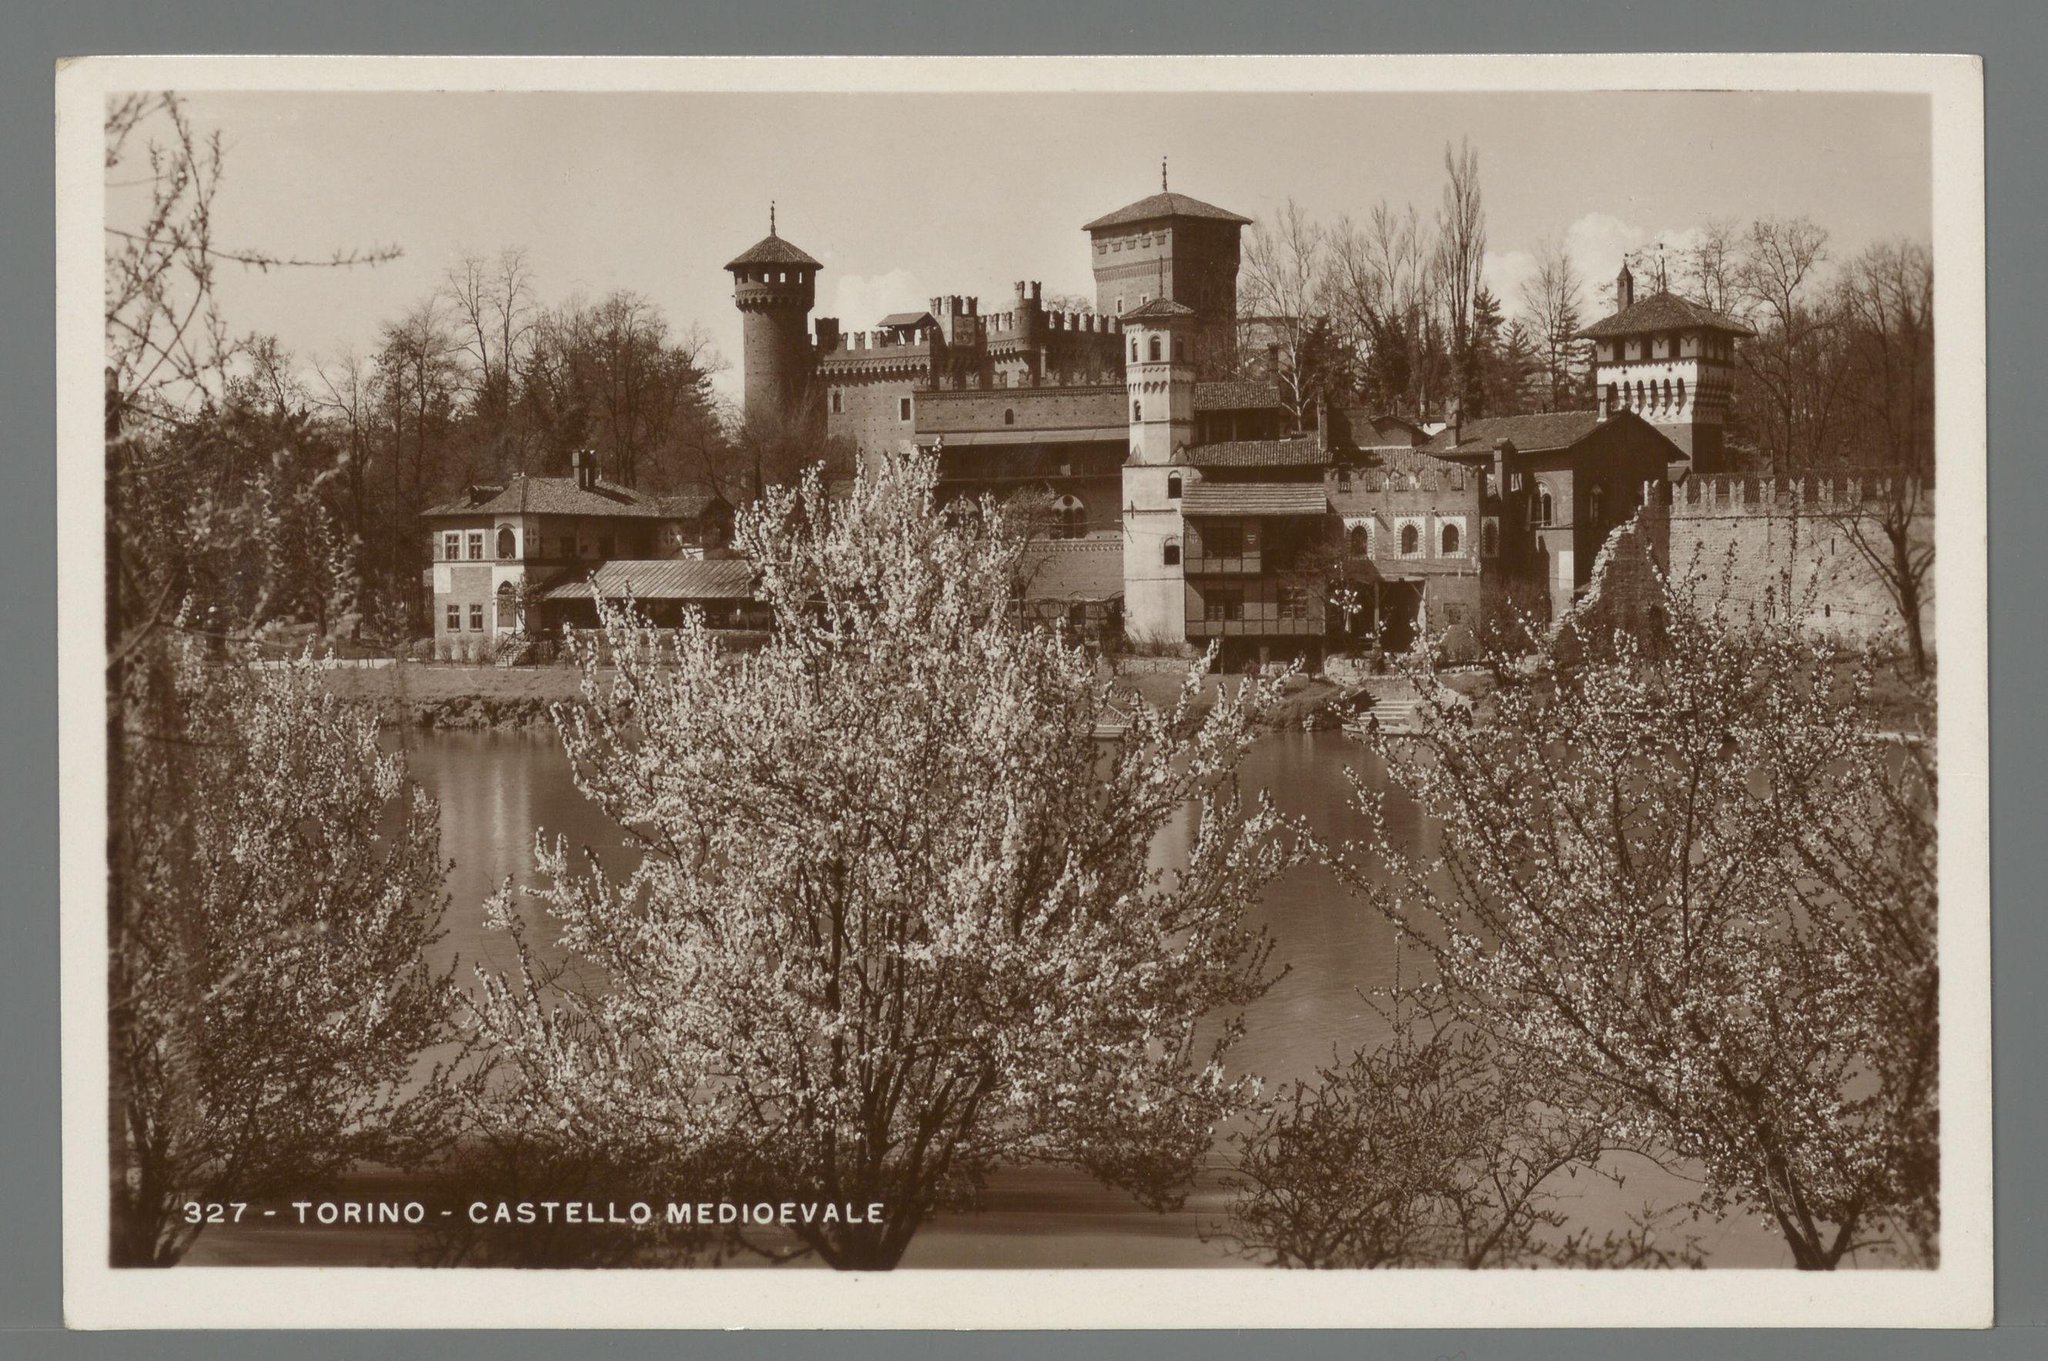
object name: ansichtkaart, prentbriefkaart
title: Torino. Castello Medioevale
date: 1908-1930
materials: photographic support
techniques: photography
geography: turin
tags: castle